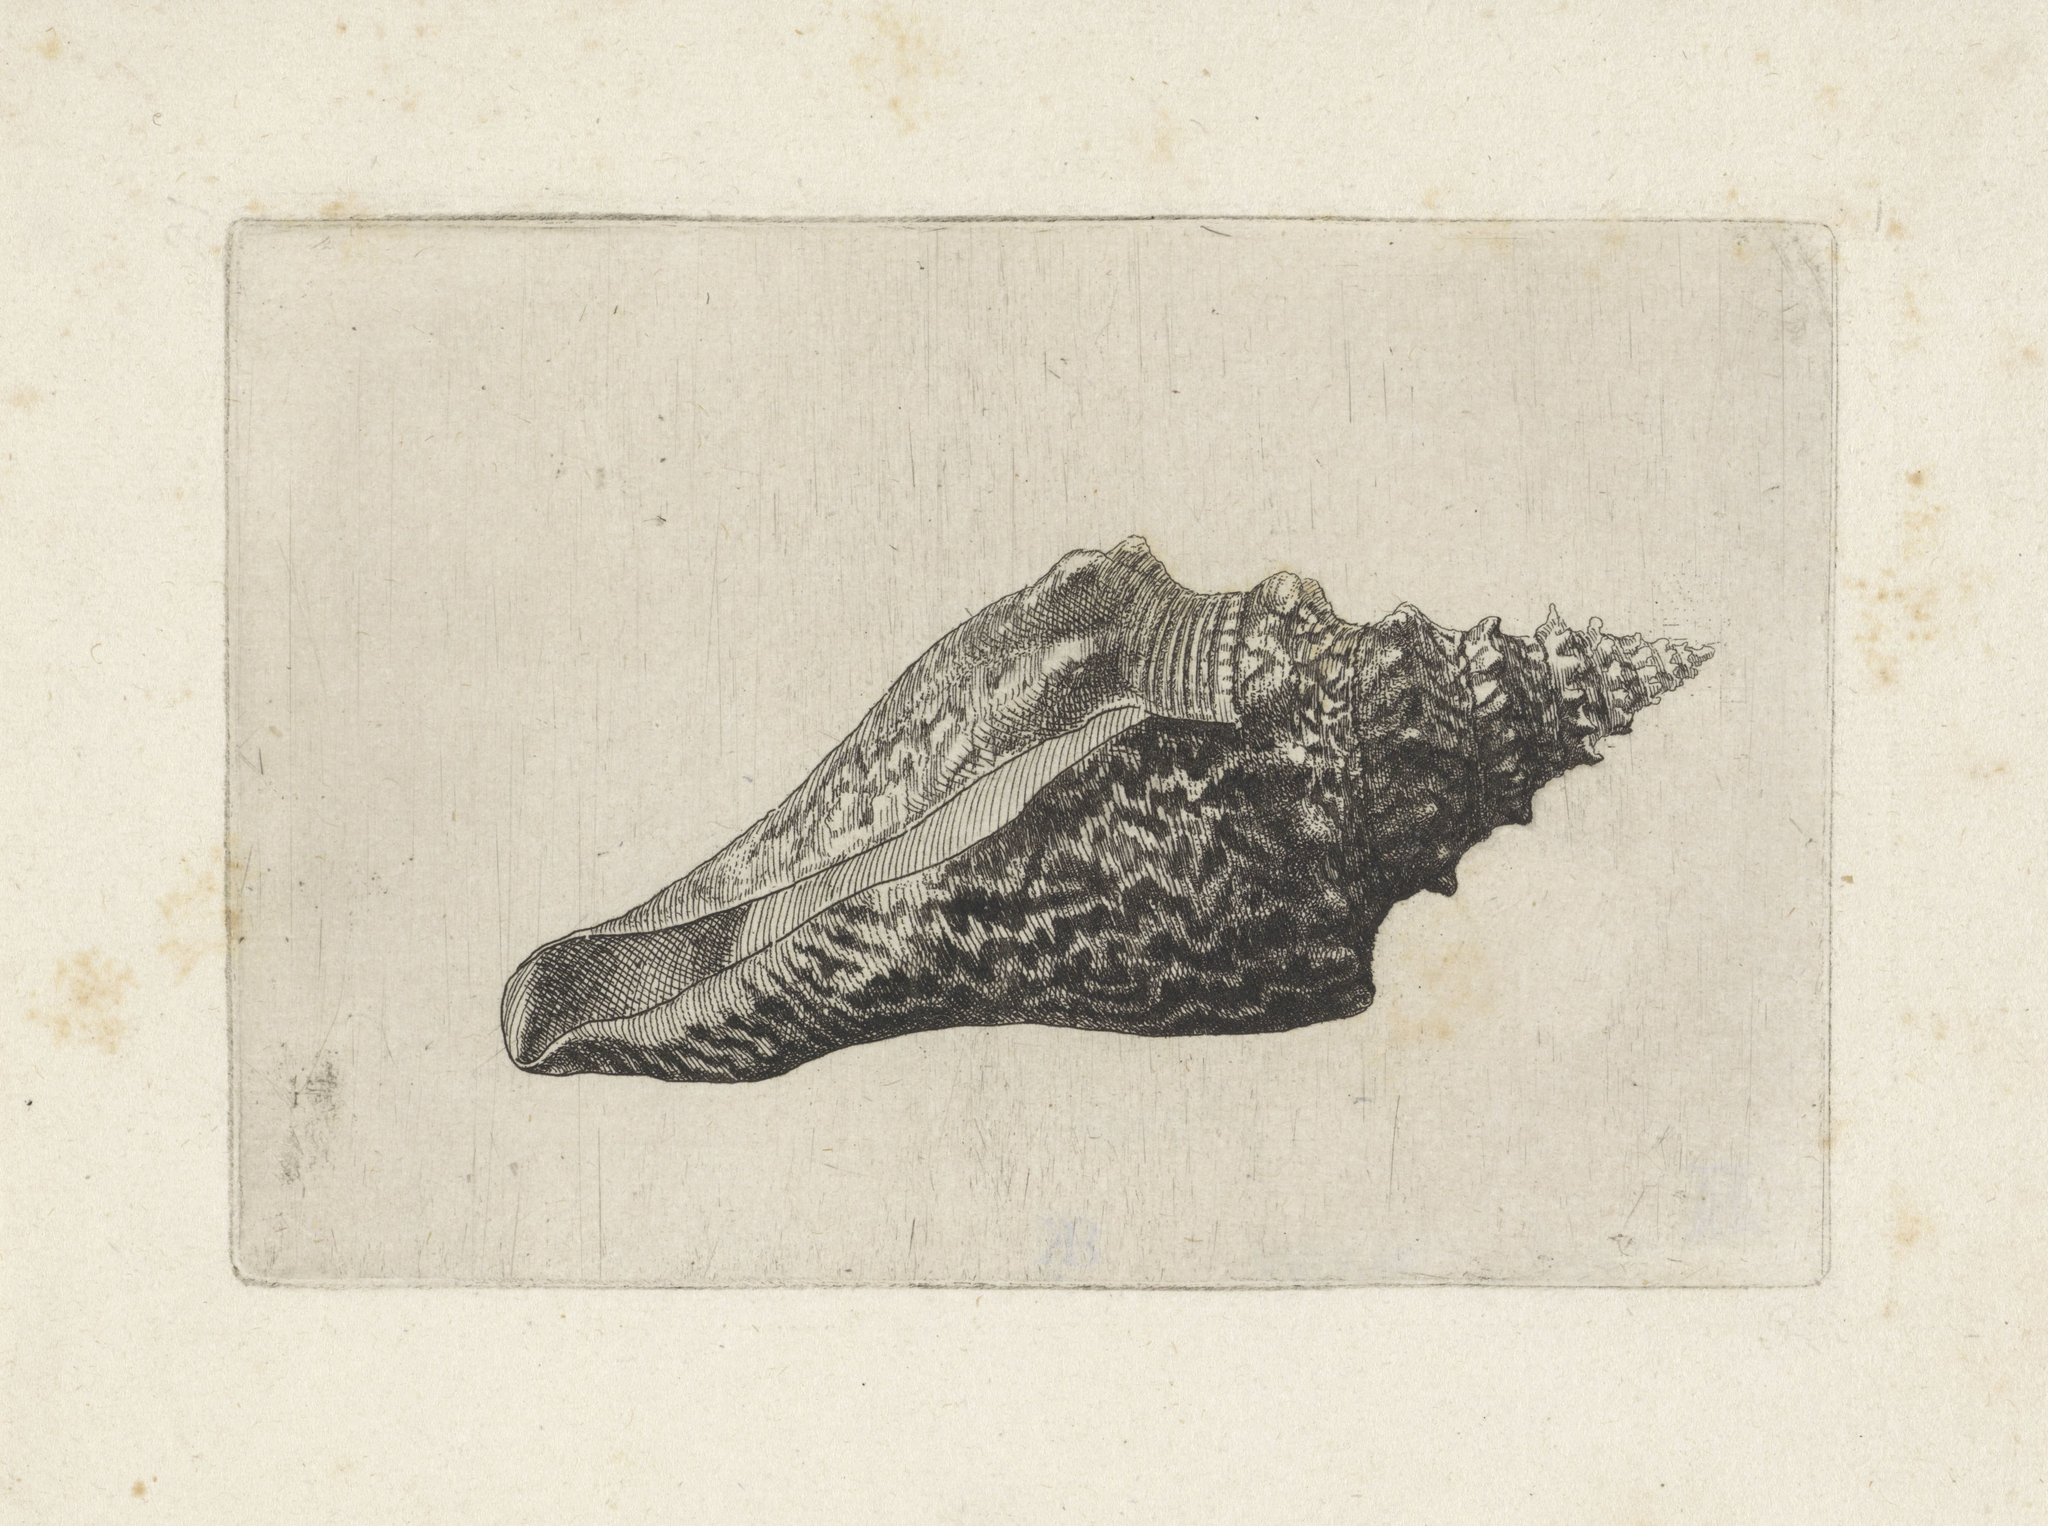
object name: print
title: Schelp, hemifusus ternatanus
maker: wenceslaus hollar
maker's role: draughtsman, print maker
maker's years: 1607-1677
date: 1644-1652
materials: paper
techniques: etching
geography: antwerp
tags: molluscs (+ shell, snail-shell etc.)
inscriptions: collector's mark: Lugt 68, collector's mark: Lugt 384, collector's mark: Lugt 654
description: Prent maakt deel uit van een 39-delige serie met verschillende soorten schelpen.